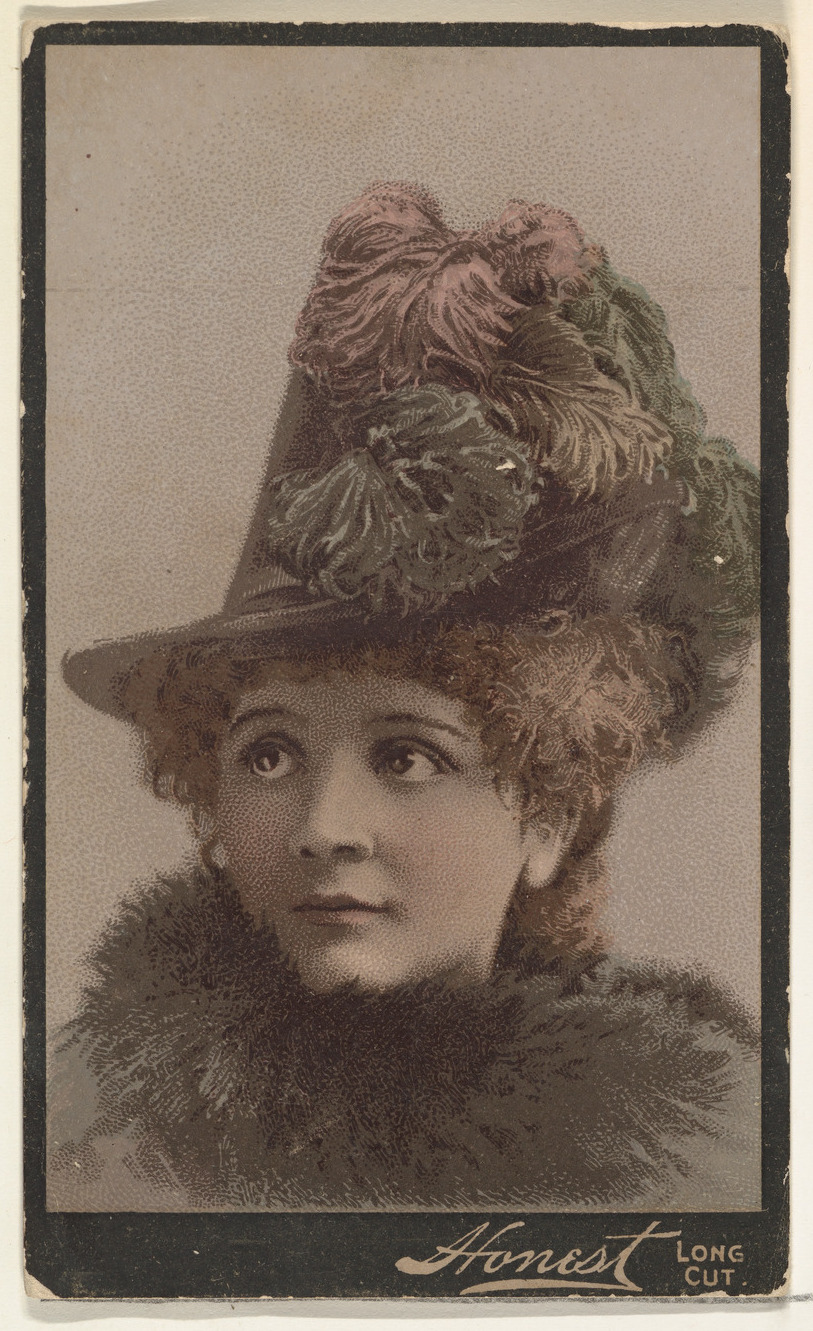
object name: print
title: Actress wearing feathered hat, from Stars of the Stage, Third Series (N131) issued by Duke Sons & Co. to promote Honest Long Cut Tobacco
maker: w. duke, sons & co.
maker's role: publisher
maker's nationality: american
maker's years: 1870-1920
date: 1891-1892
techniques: color lithograph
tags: hats,portraits,women,actresses